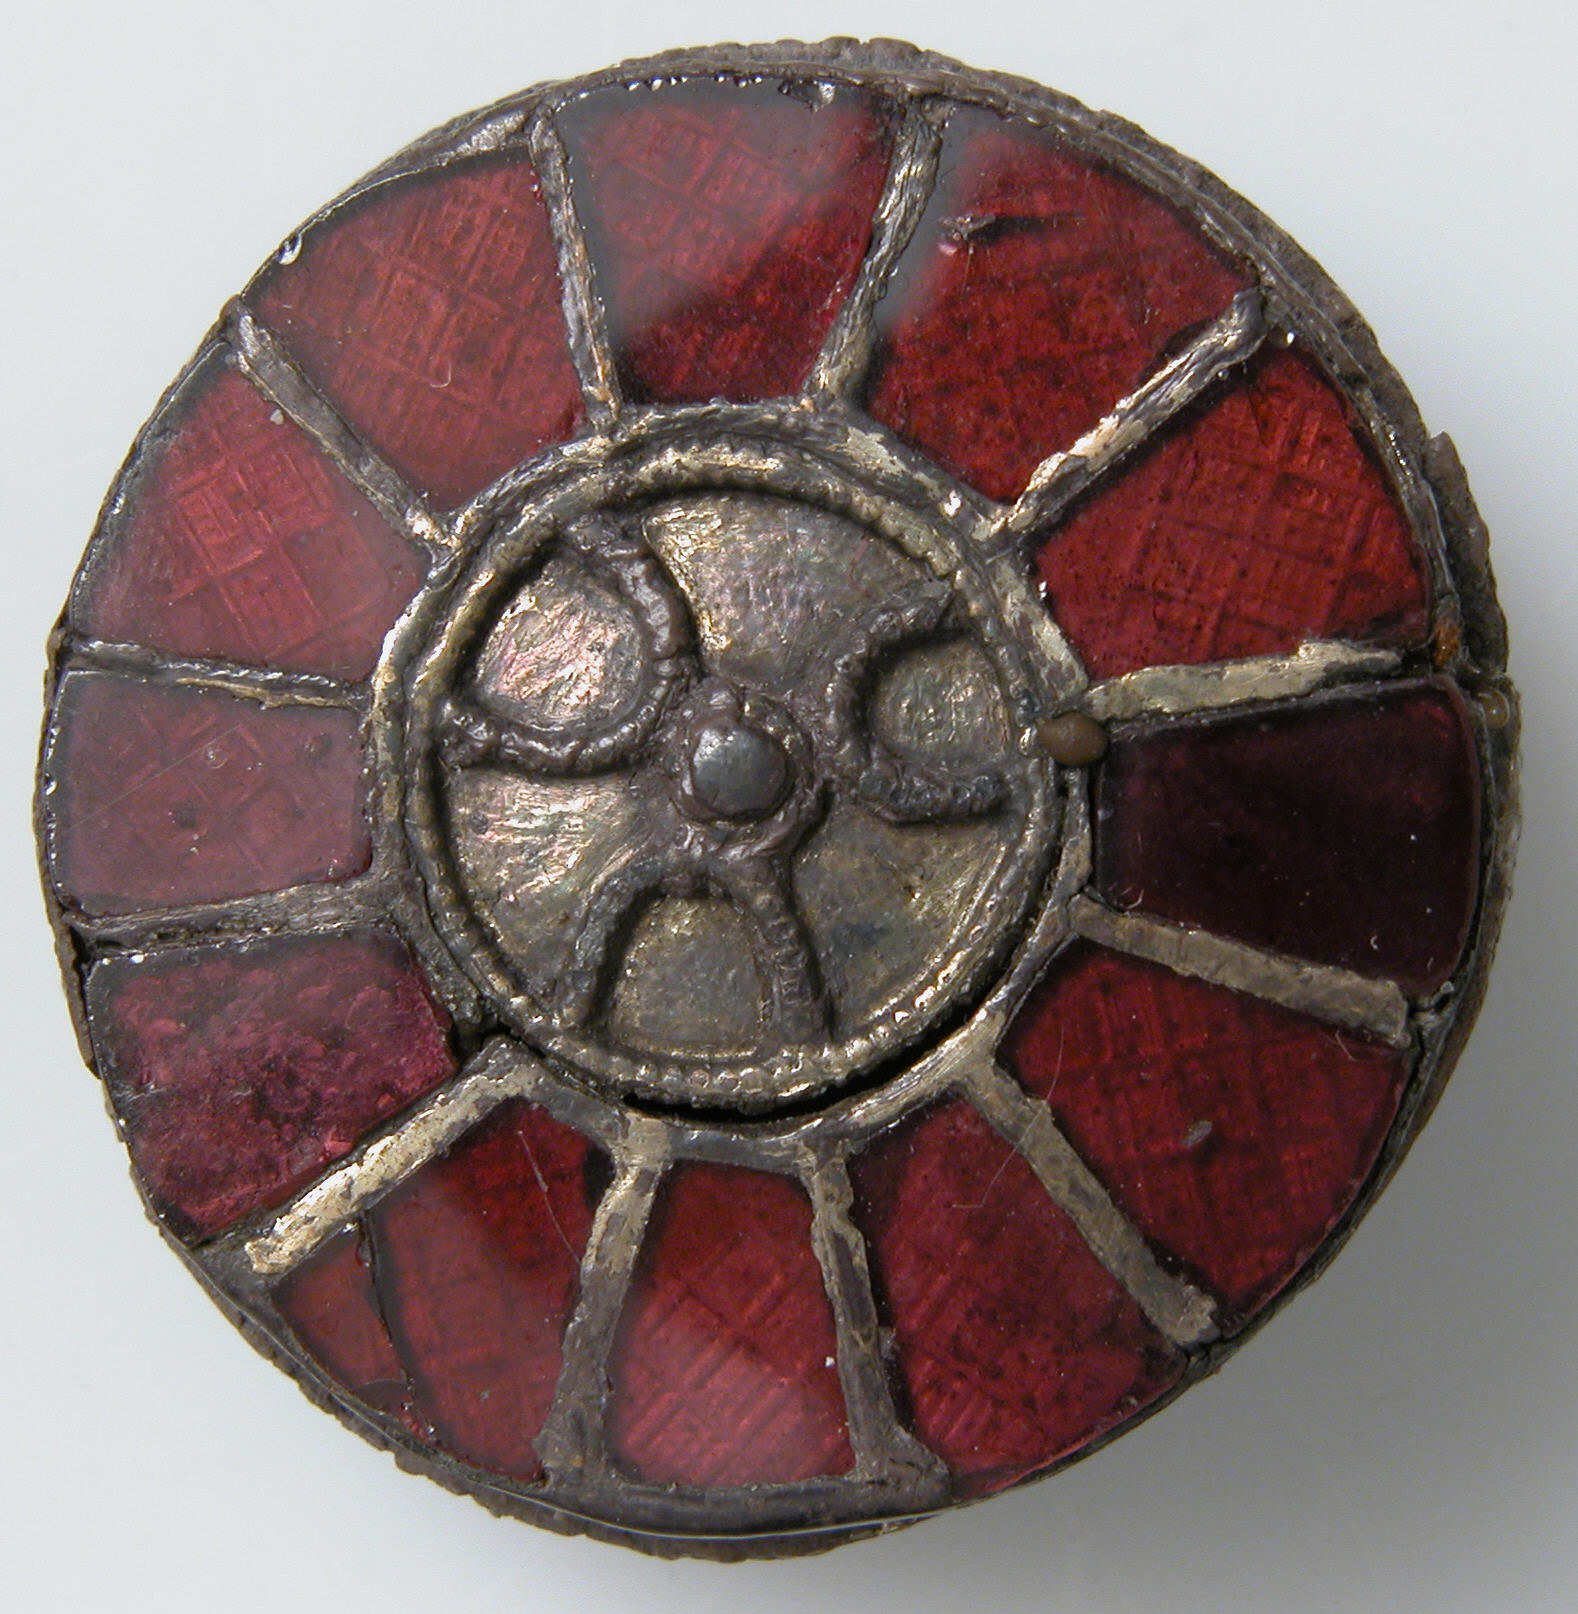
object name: brooch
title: Disk Brooch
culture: frankish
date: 501-600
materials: foil, gemstone, gilt, glass, paste, silver, metal